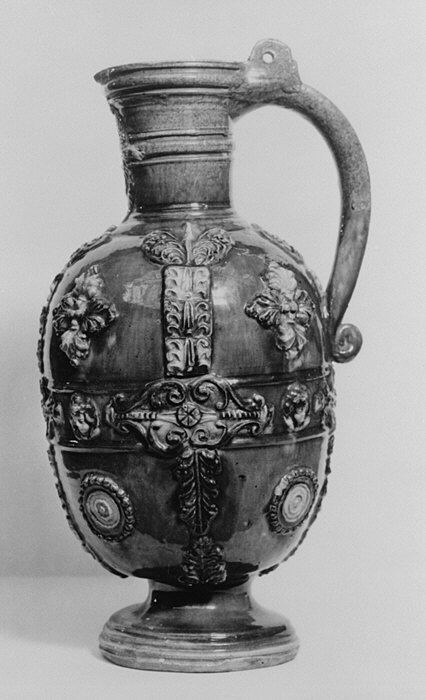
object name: ewer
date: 1601-1700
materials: earthenware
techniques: glazing